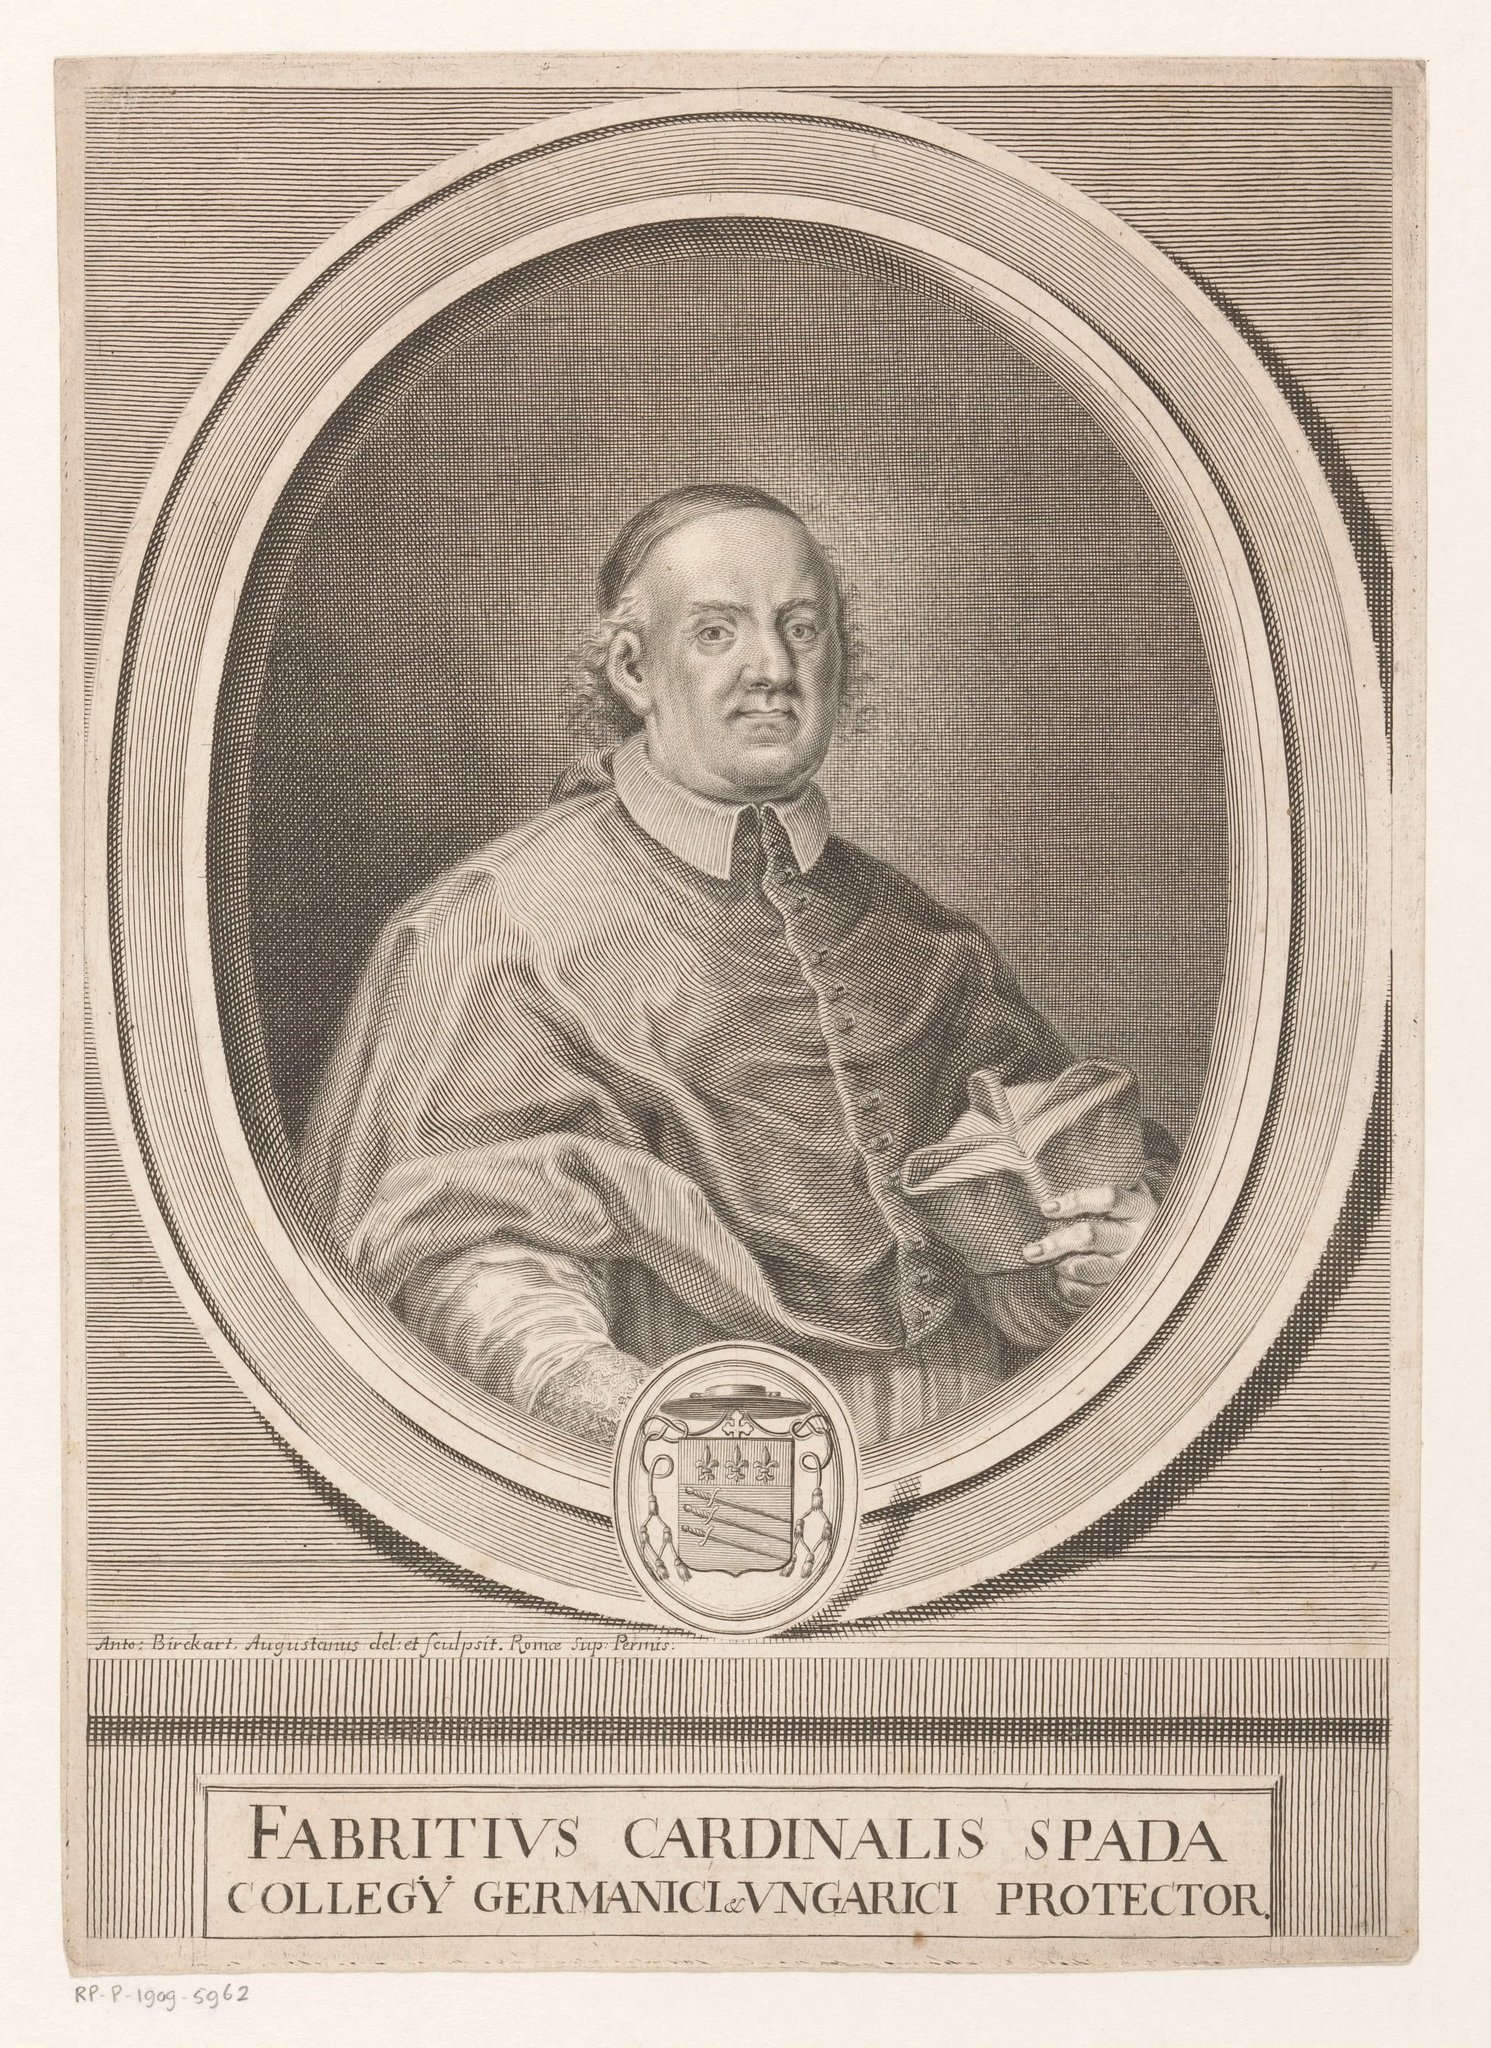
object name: print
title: Portret van Fabrizio Spada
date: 1704-1710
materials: paper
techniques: engraving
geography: rome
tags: historical persons, armorial bearing, heraldry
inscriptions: collector's mark: Lugt 2228